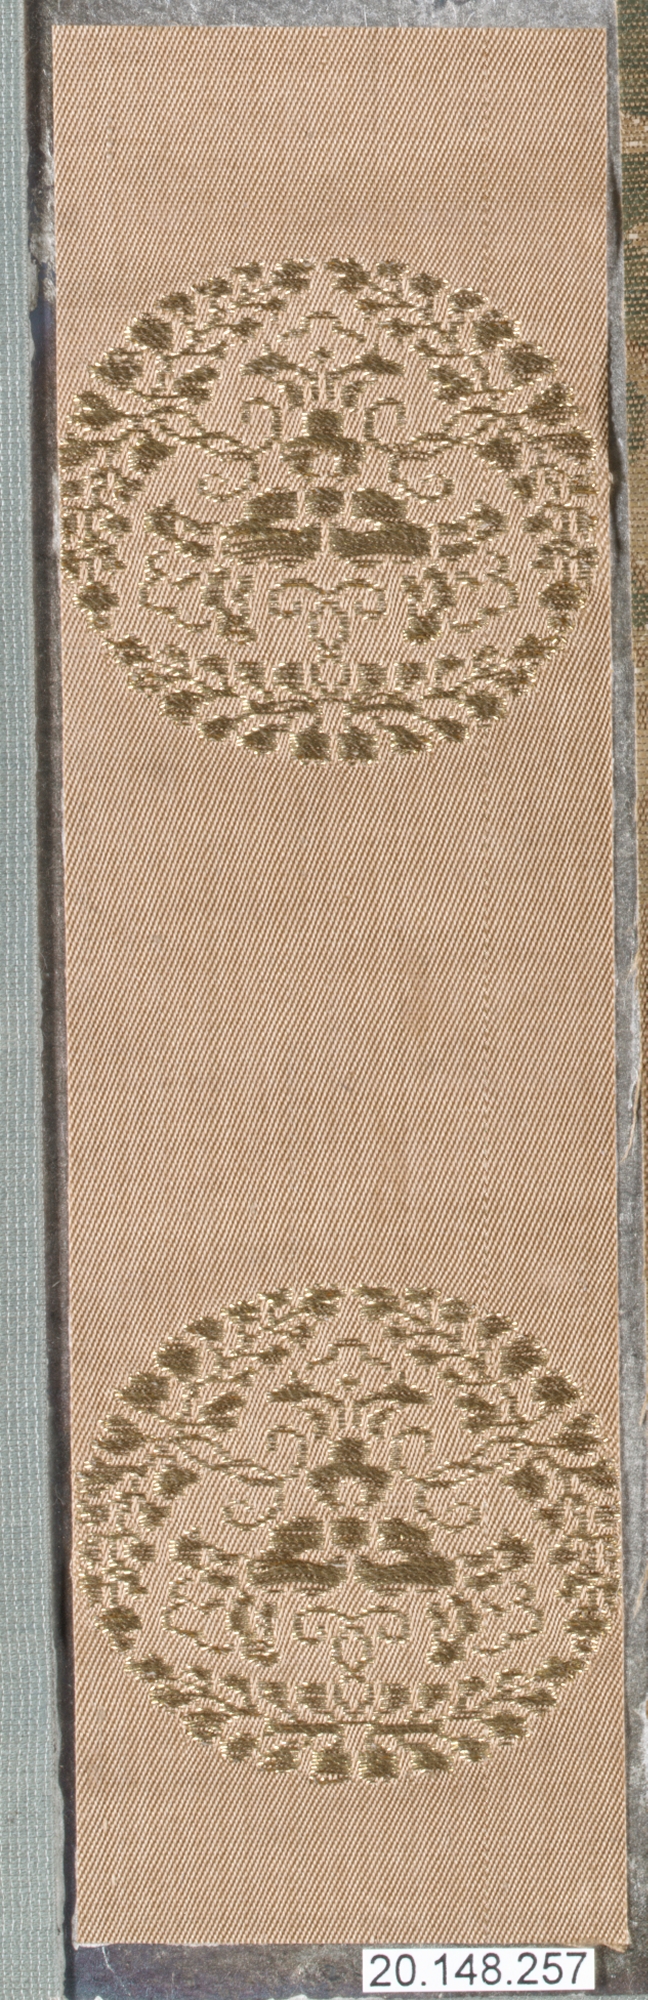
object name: piece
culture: japanese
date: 1601-1700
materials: silk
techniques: compound weave